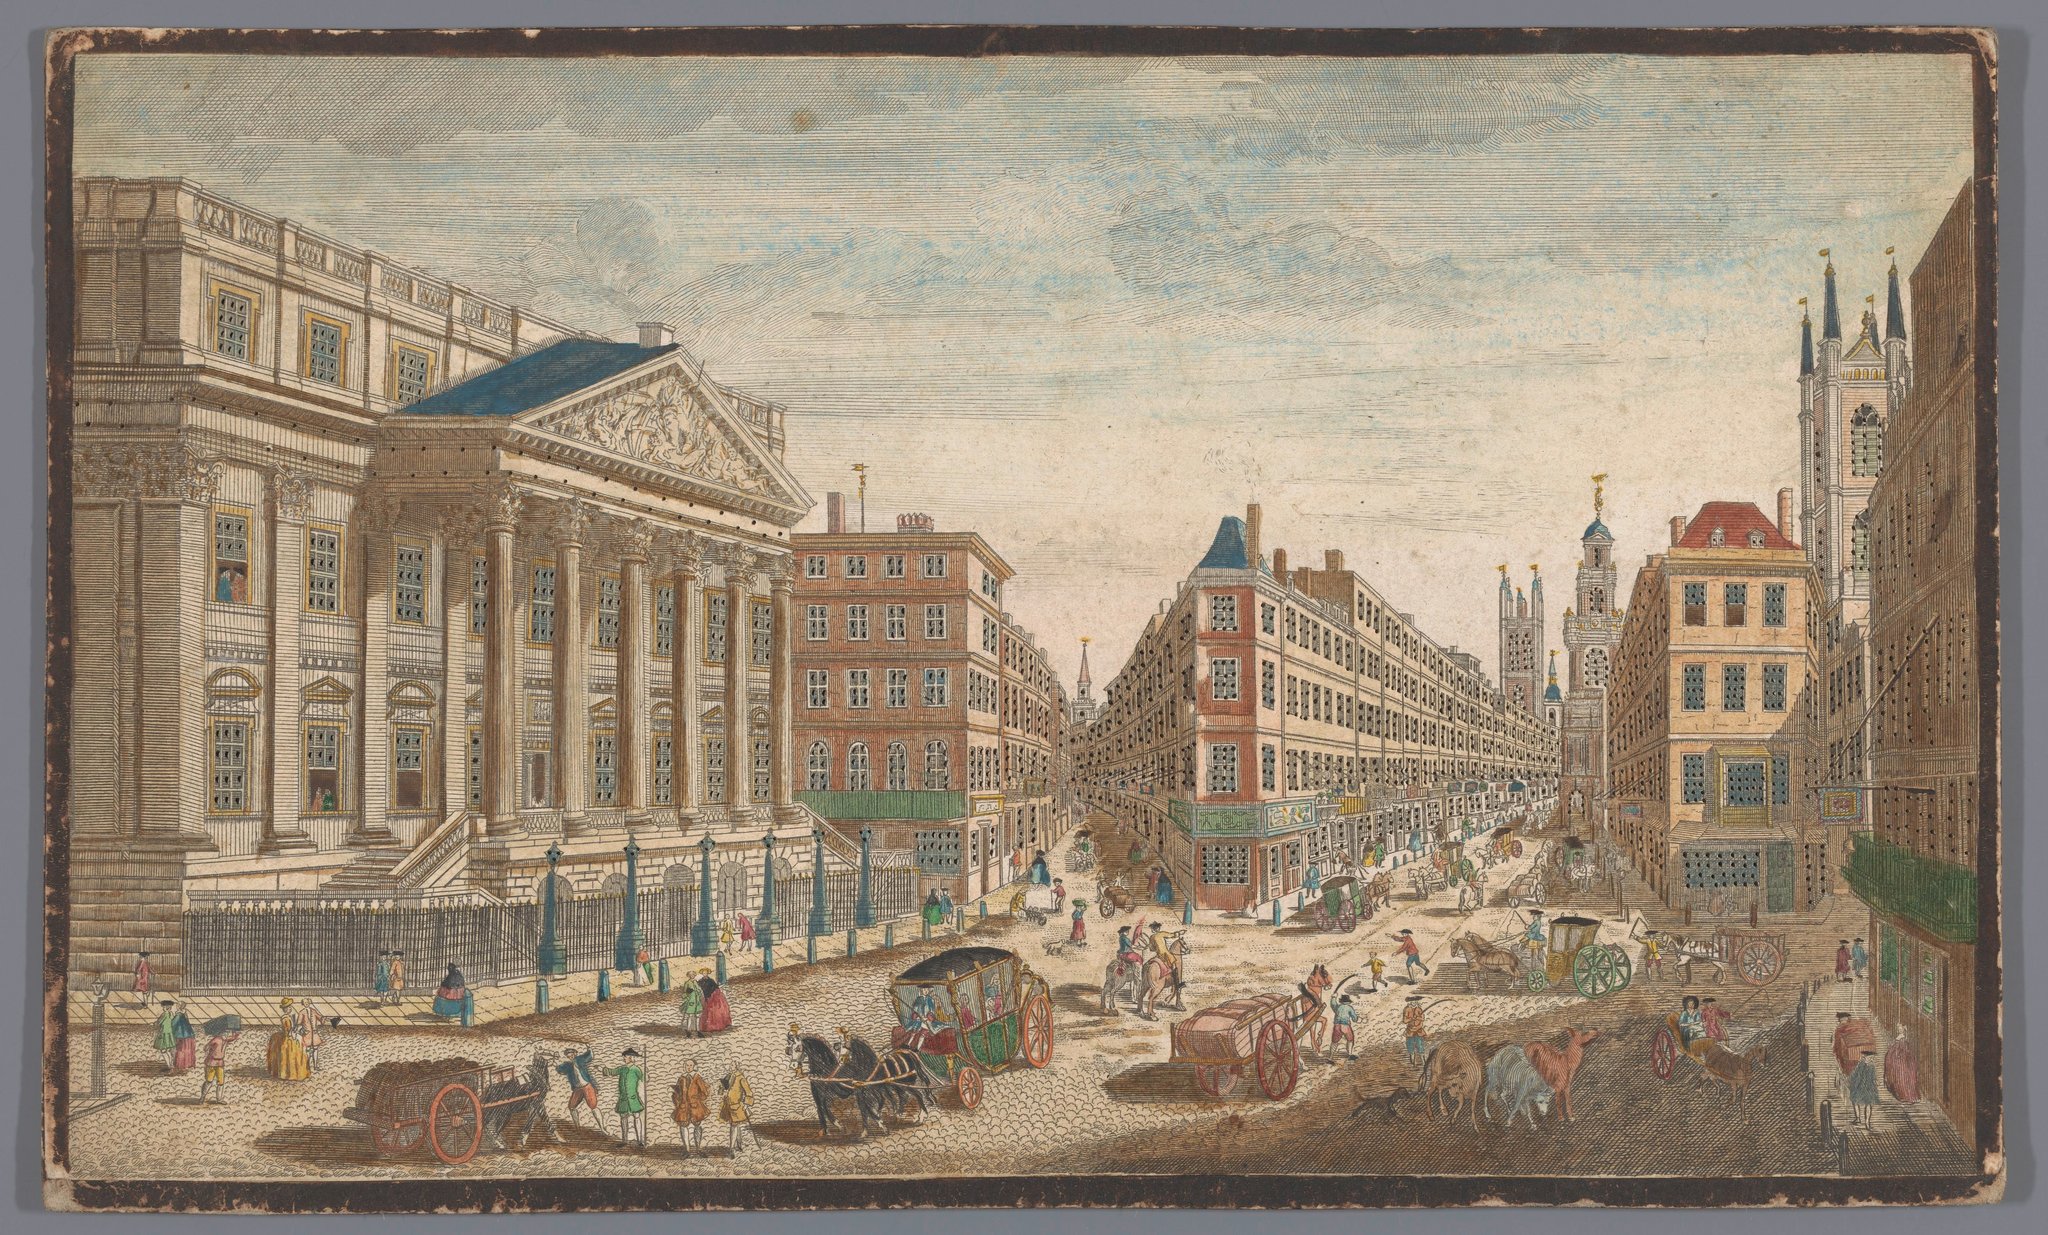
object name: print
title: Gezicht op het Mansion House te Londen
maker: Anonymous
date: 1751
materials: cardboard, paint, paper, watercolor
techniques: brush, cutting, etching, perforating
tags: mayor, burgomaster, civic architecture; edifices; dwellings, street (+ city(-scape) with figures, staffage)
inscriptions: collector's mark: Lugt 2233